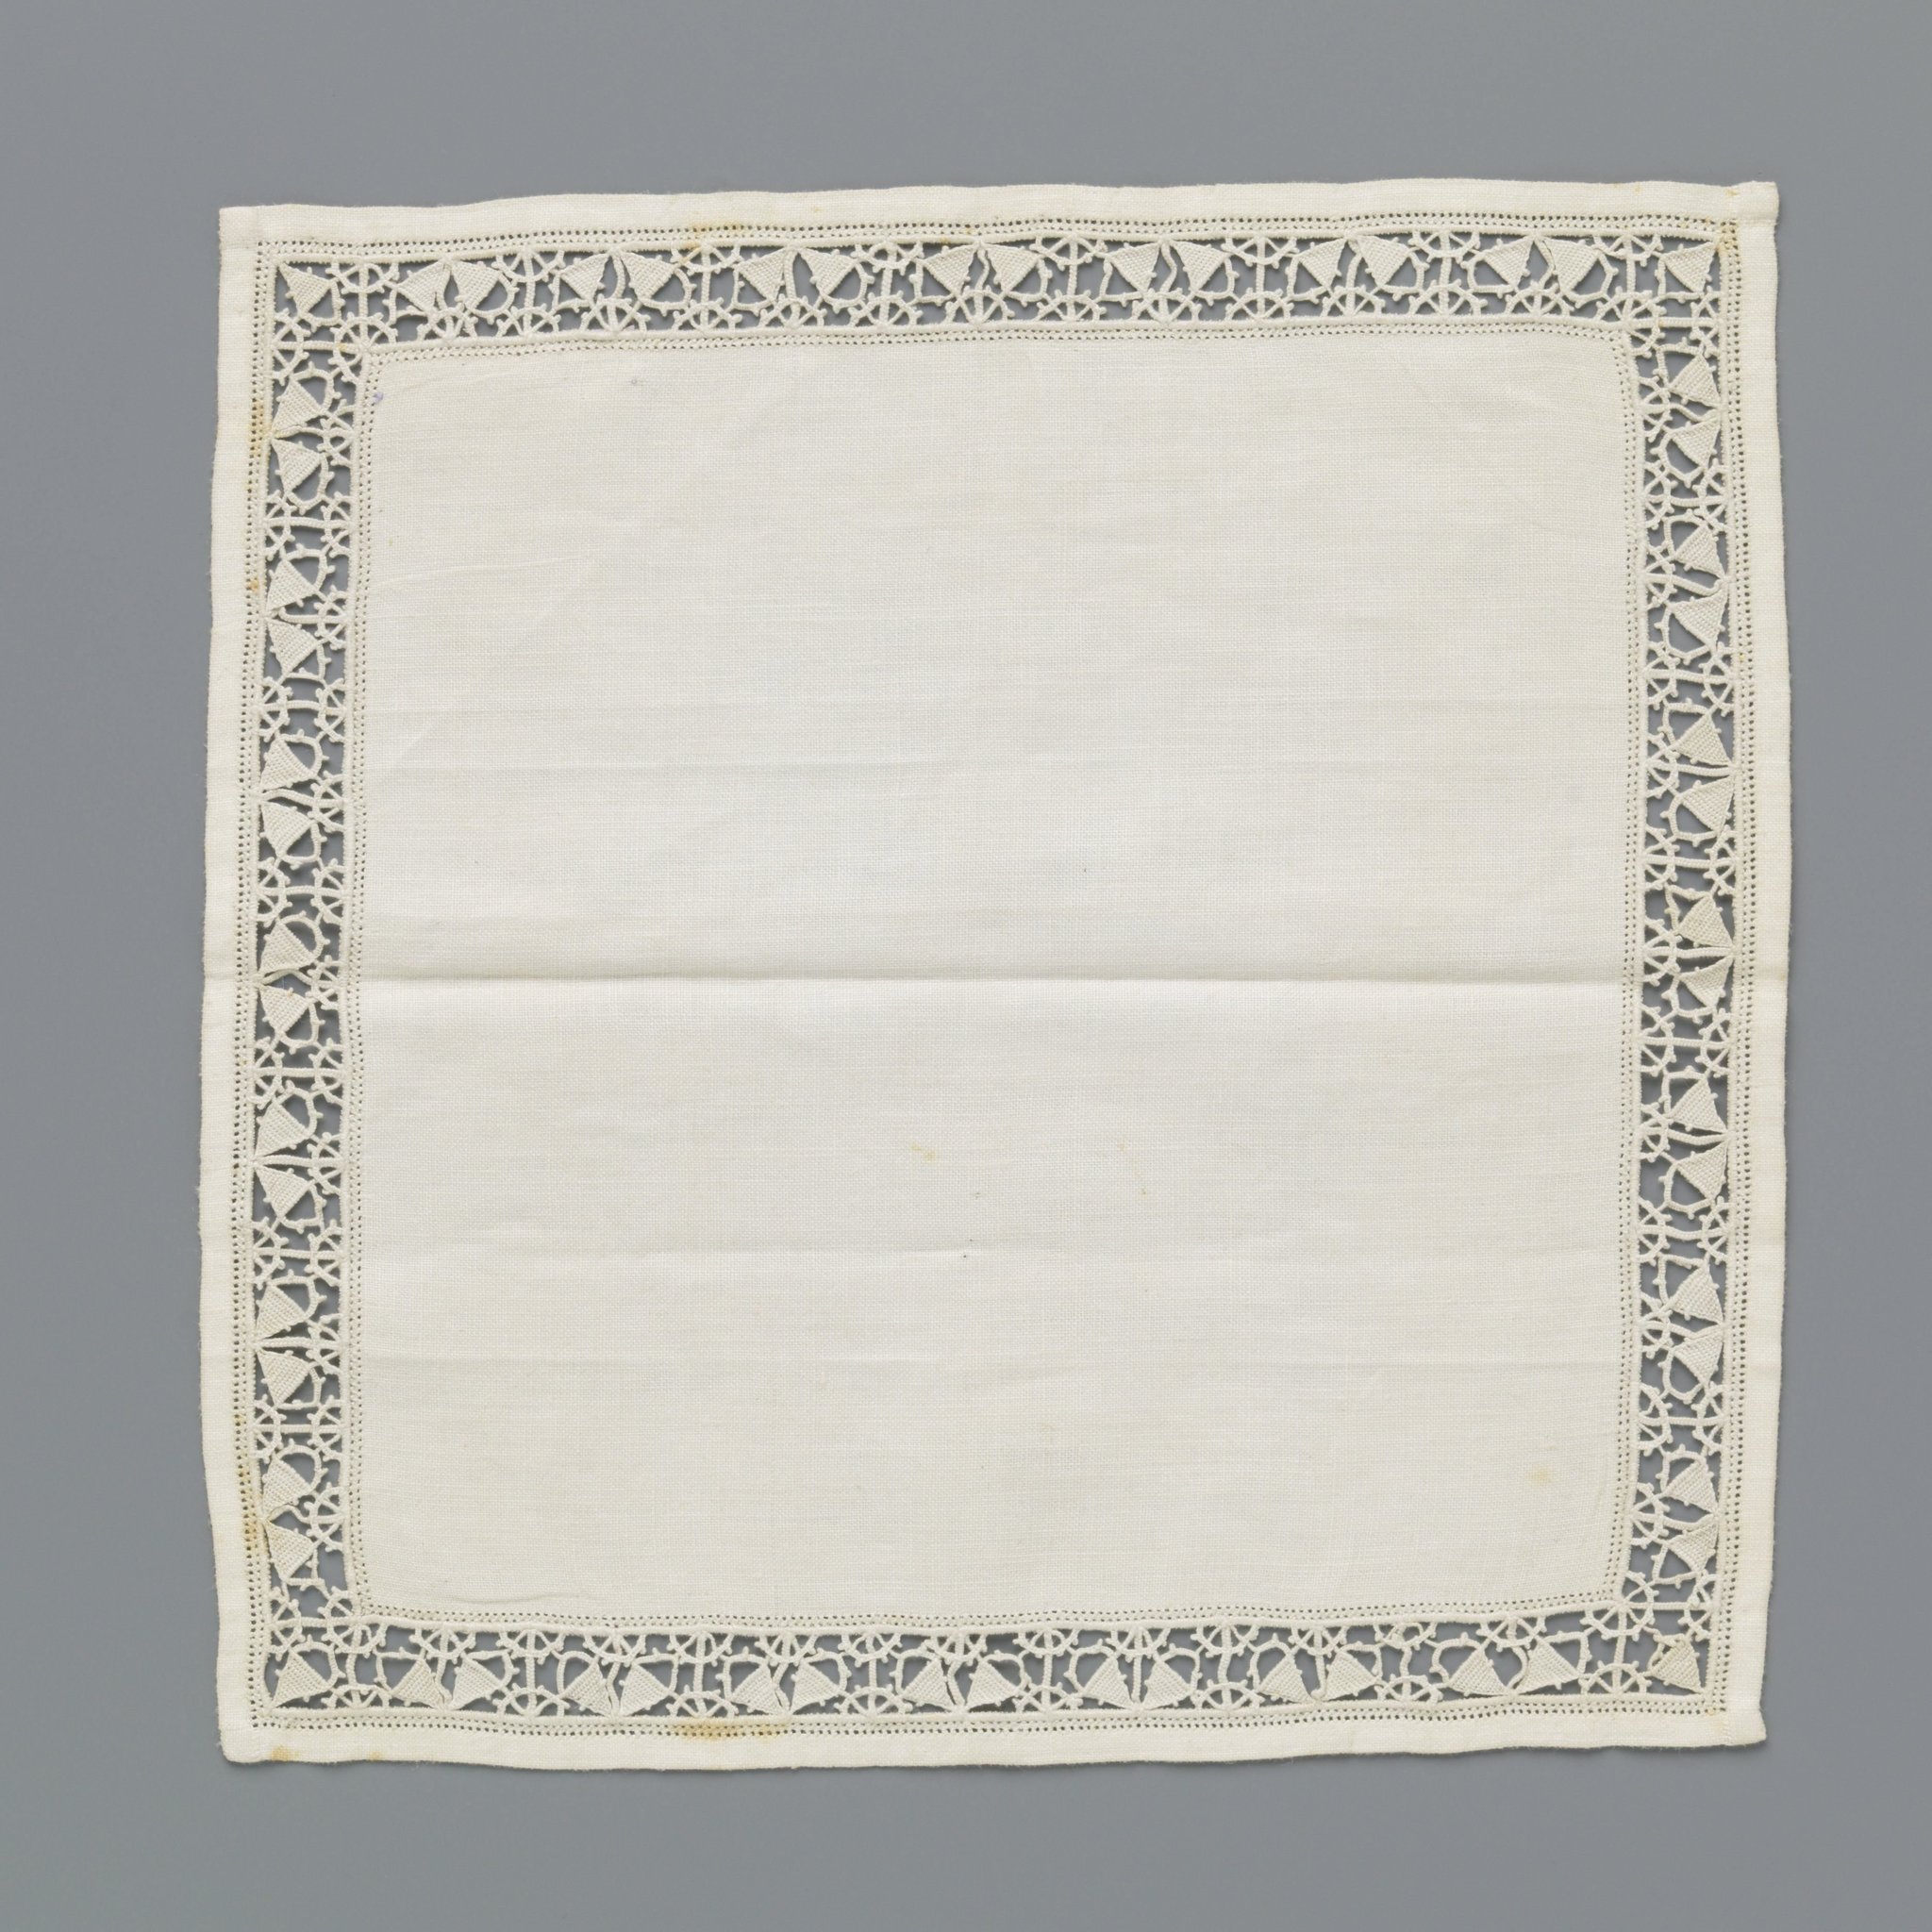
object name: kleed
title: Linnen kleed met in de rand een strook reticella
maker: Anonymous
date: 1900-1949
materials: linen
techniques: weave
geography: south africa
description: Linnen kleed met in de rand een strook naaldkant - reticella - met een geometrisch motief. Vierkant model.